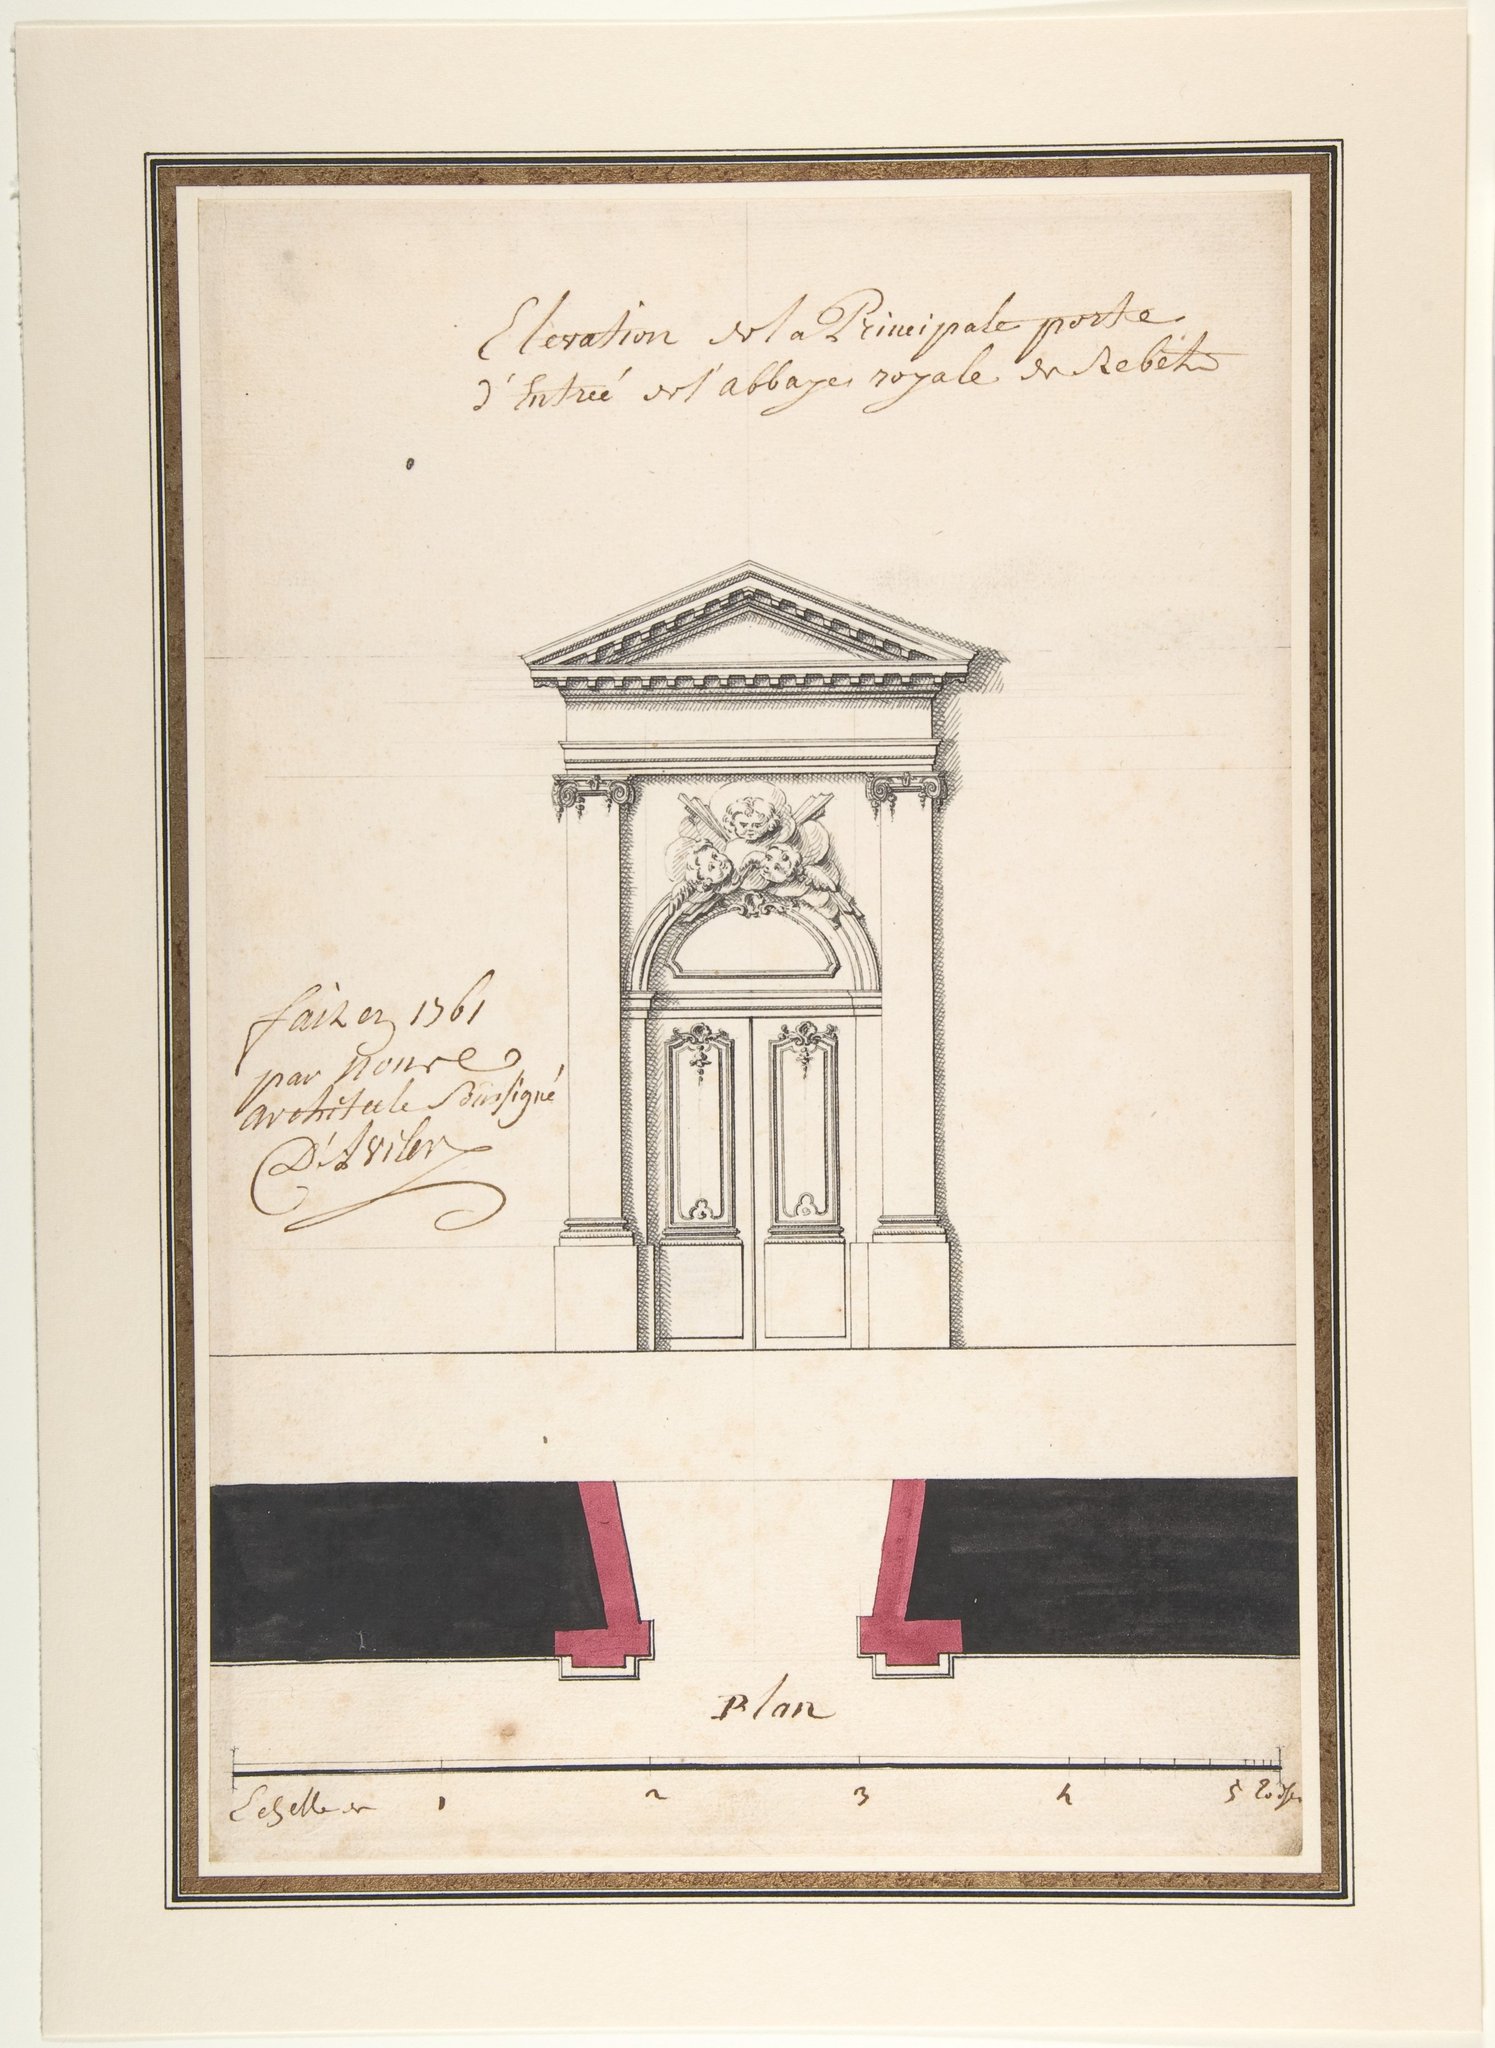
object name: drawing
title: Design for an Elevation of a Gateway, Abbey at Rebais (Seine et Marne)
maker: claude louis d'aviler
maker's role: artist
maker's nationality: french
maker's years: 1764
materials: graphite, ink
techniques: pen, drawing, wash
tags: architecture,doors,abbeys